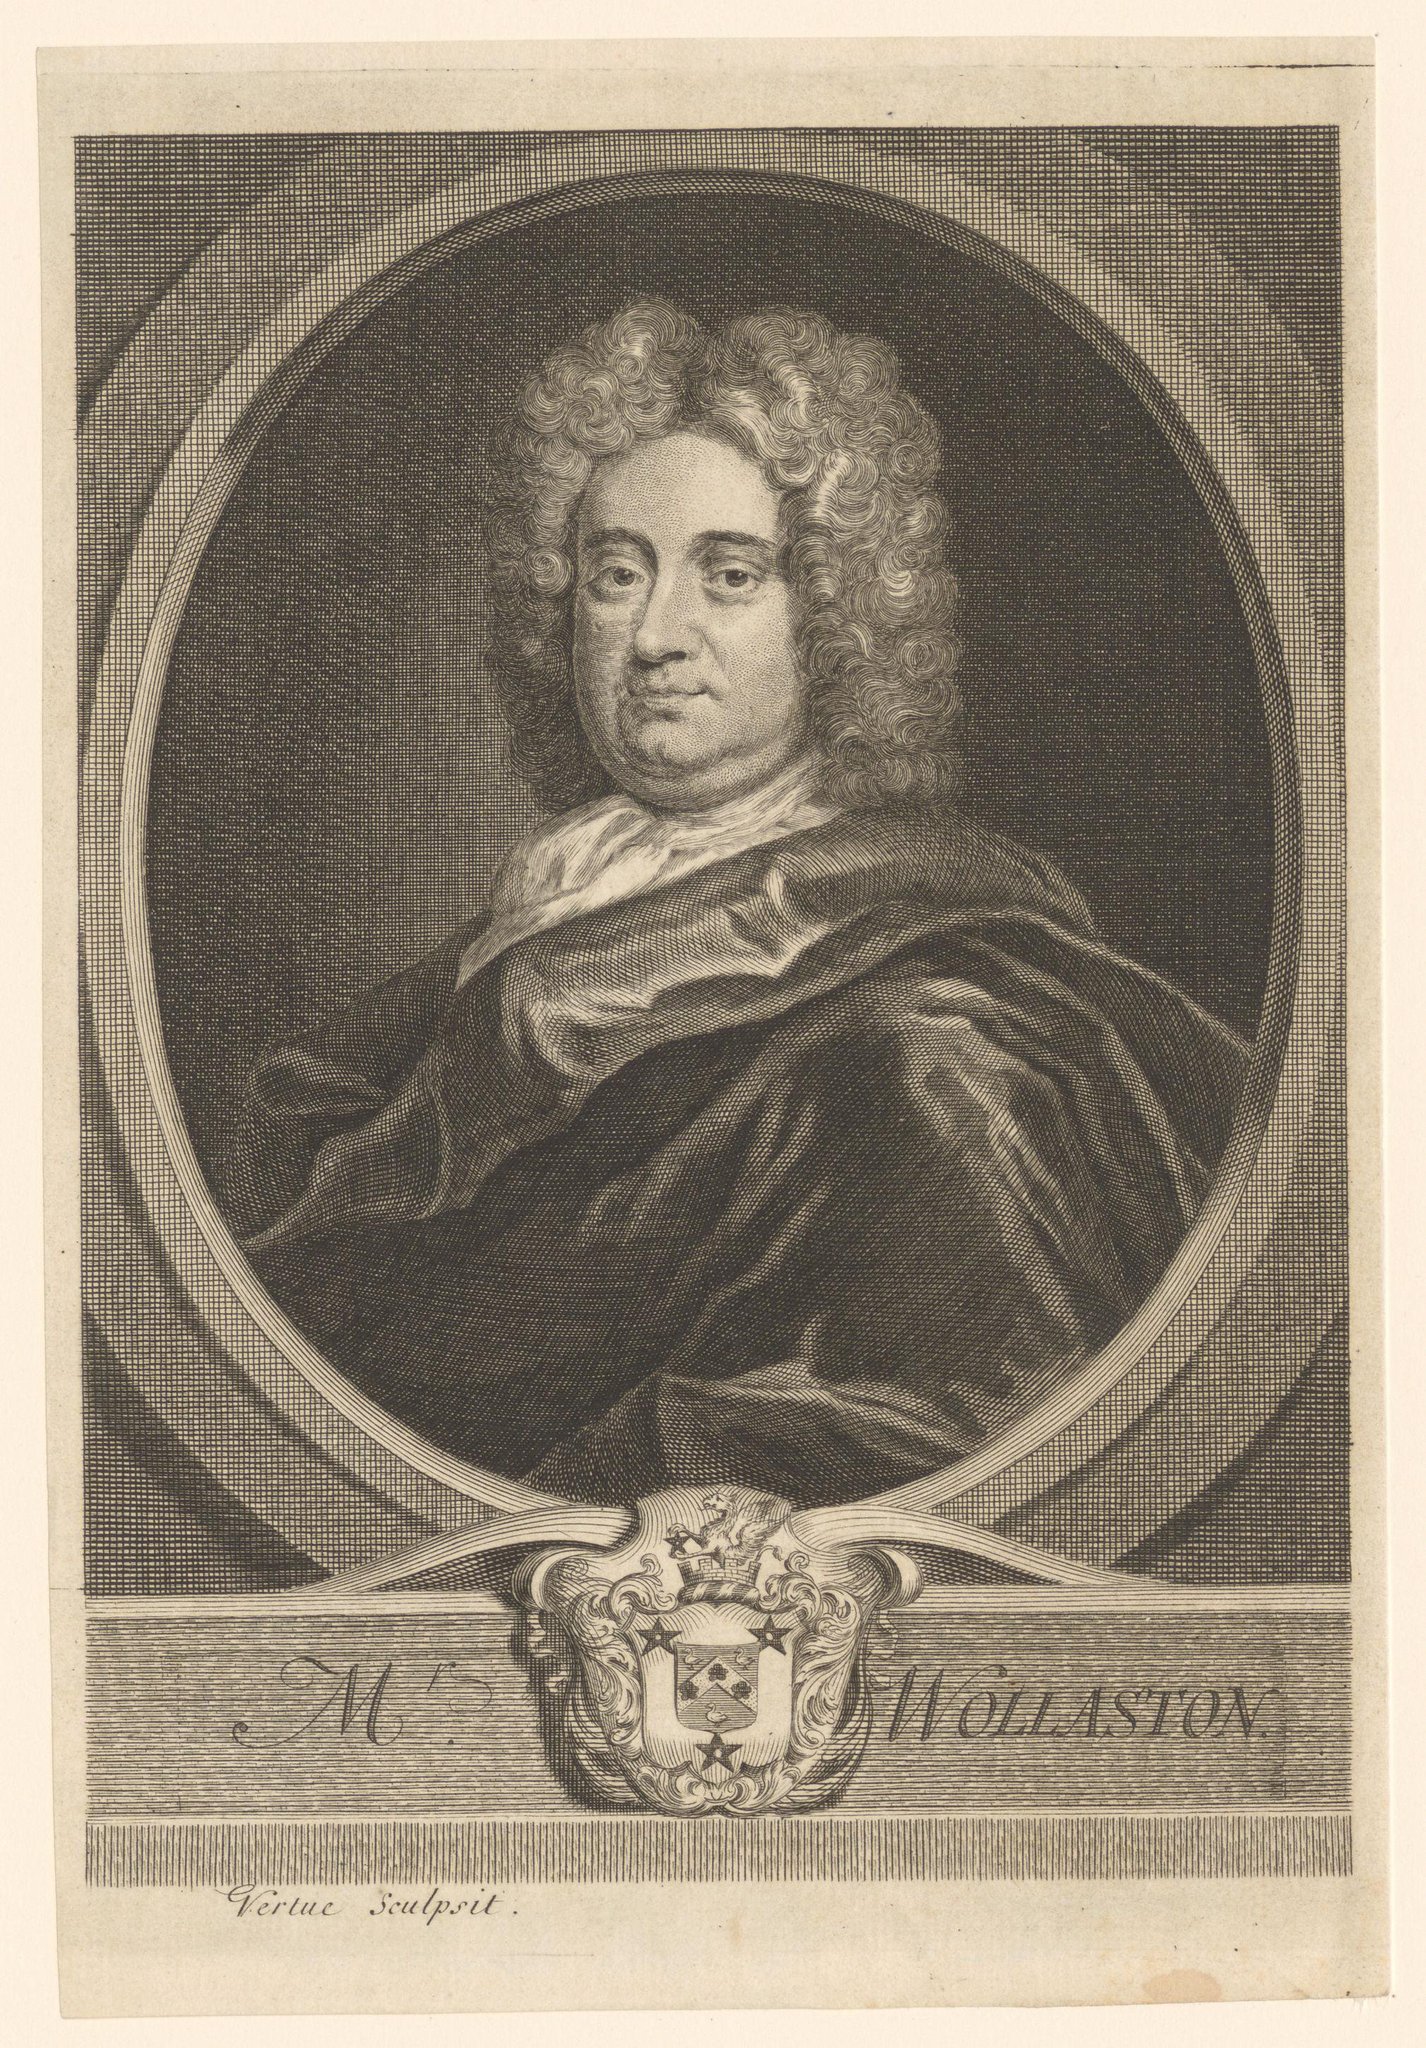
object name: print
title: Portret van William Wollaston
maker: george vertue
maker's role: print maker, publisher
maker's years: 1684-1756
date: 1694-1756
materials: paper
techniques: engraving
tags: london, historical persons, scholar, philosopher (+ portrait of scholar, scientist)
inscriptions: collector's mark: Lugt 2228